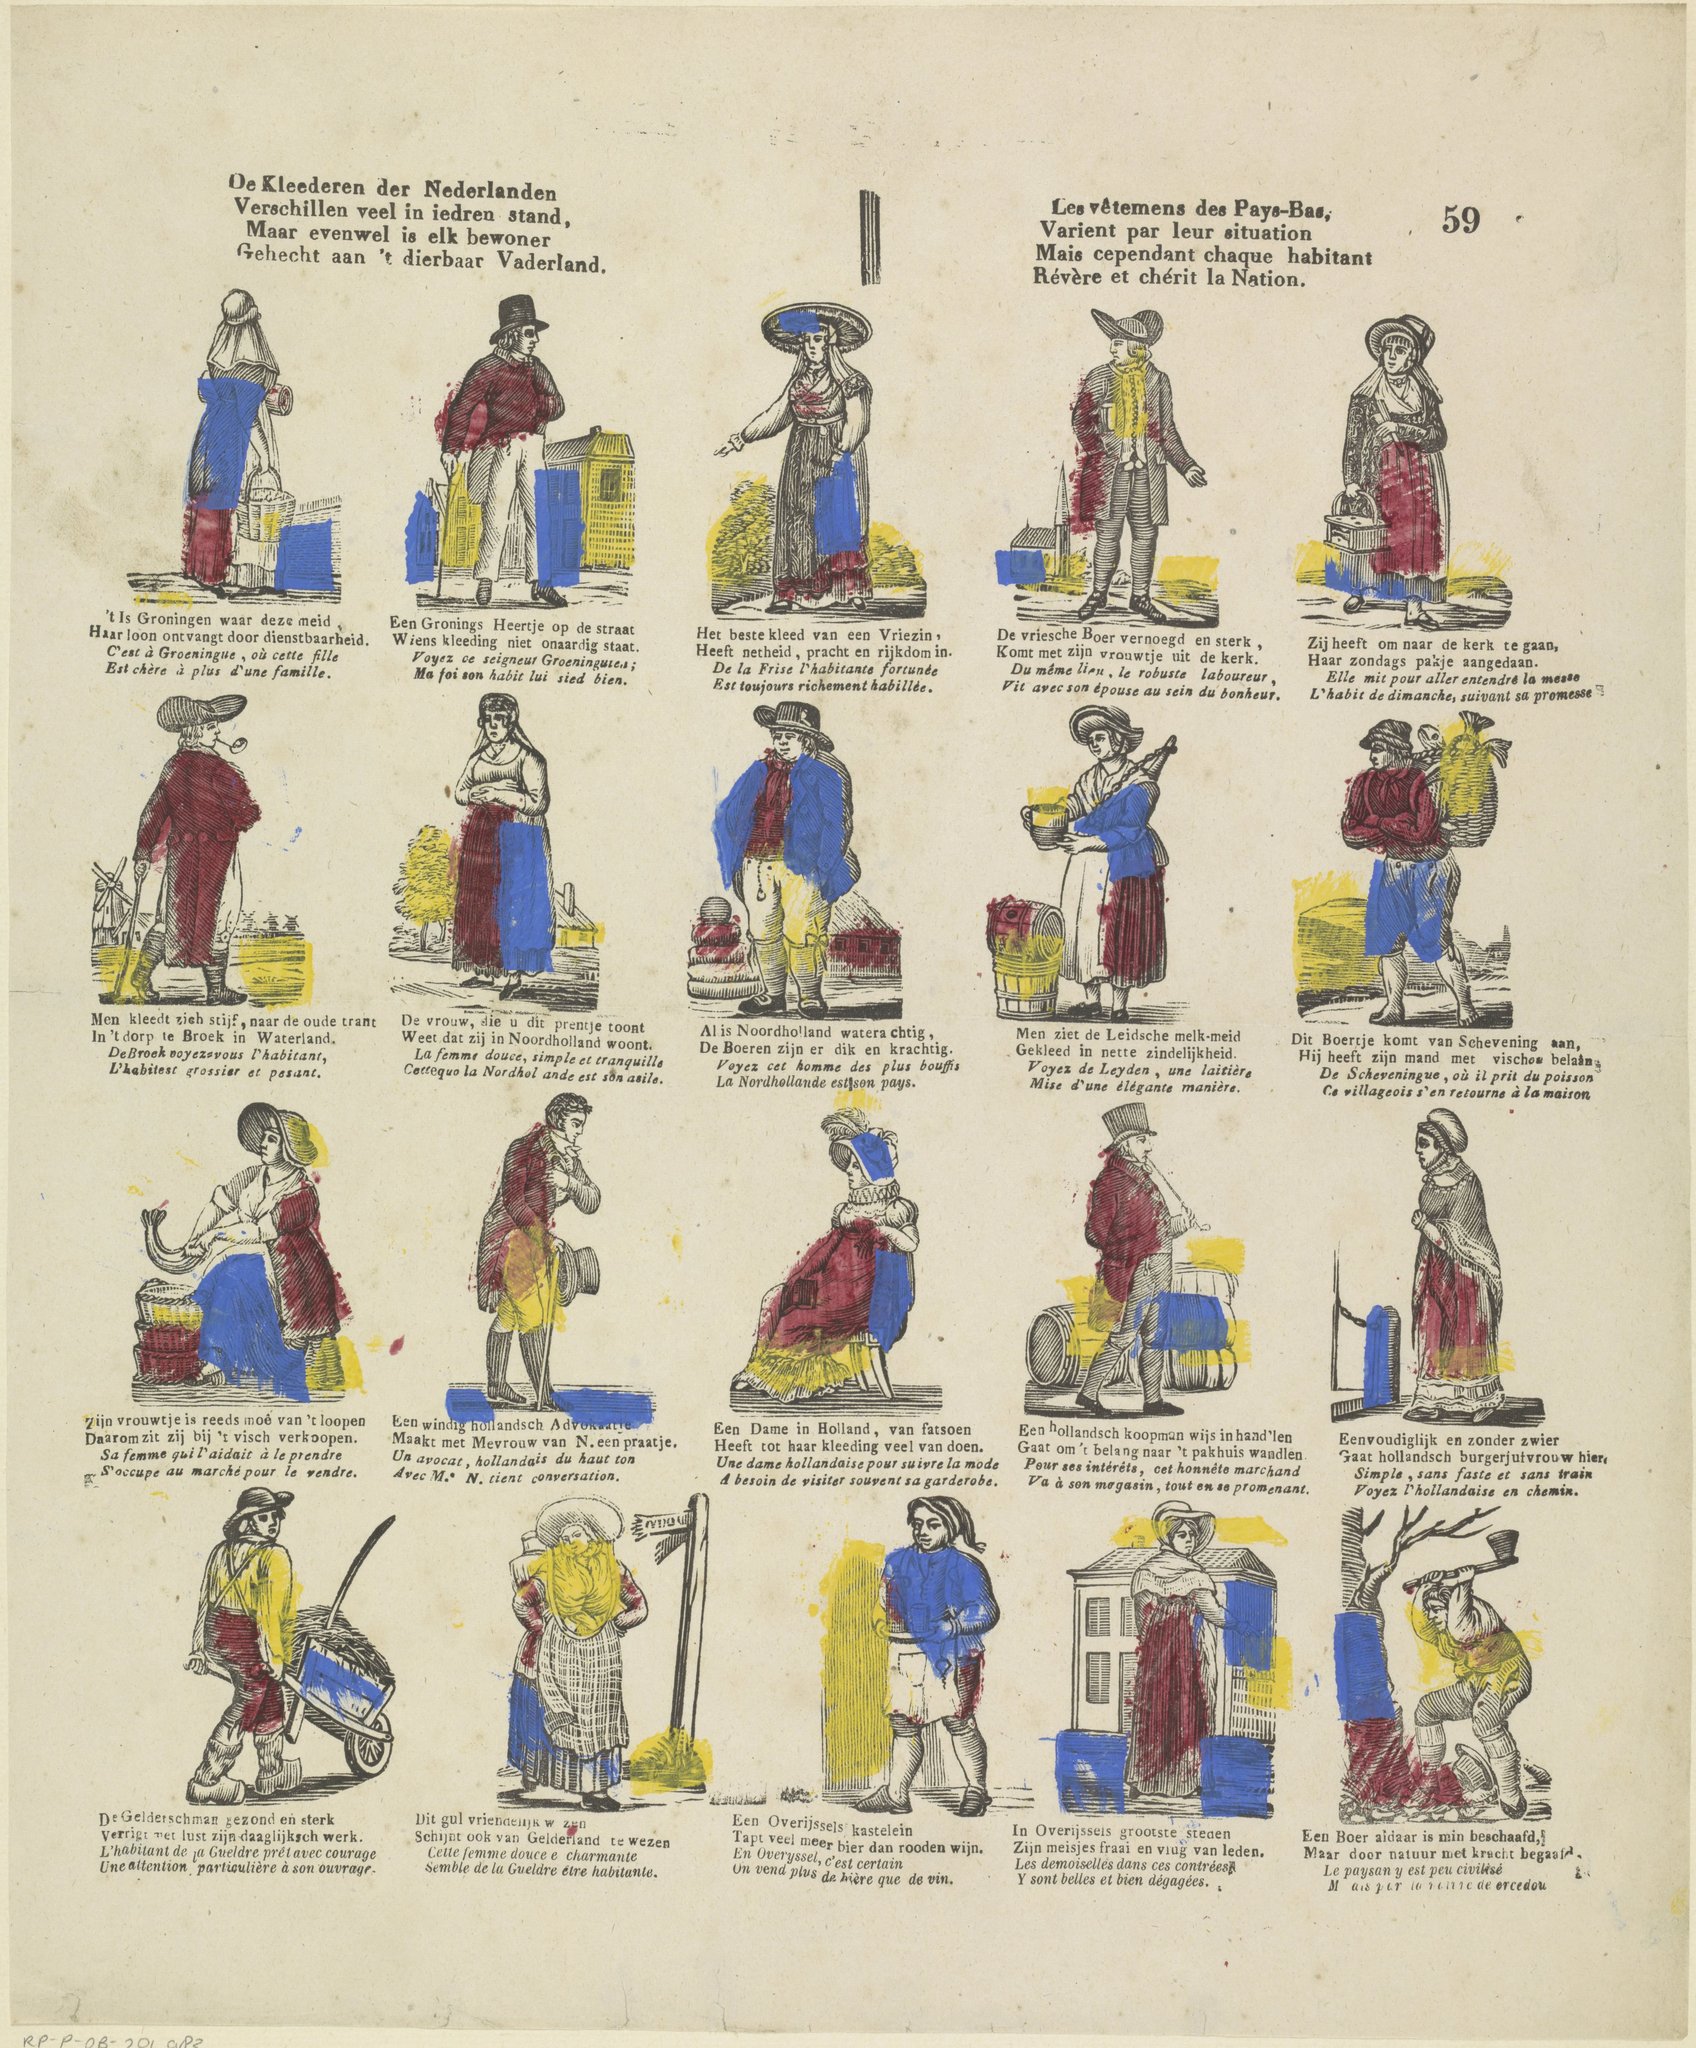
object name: print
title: De kleederen der Nederlanden / Verschillen veel in iedren stand [(...)]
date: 1800-1833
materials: paper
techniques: colour, letterpress printing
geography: turnhout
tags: historical costume, folk costume, regional costume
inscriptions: collector's mark: Lugt 2760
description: Blad met 20 voorstellingen van personen in verschillende Nederlandse klederdrachten. Onder elke afbeelding een tweeregelig vers in het Nederlands en in het Frans. Genummerd rechtsboven: 59.